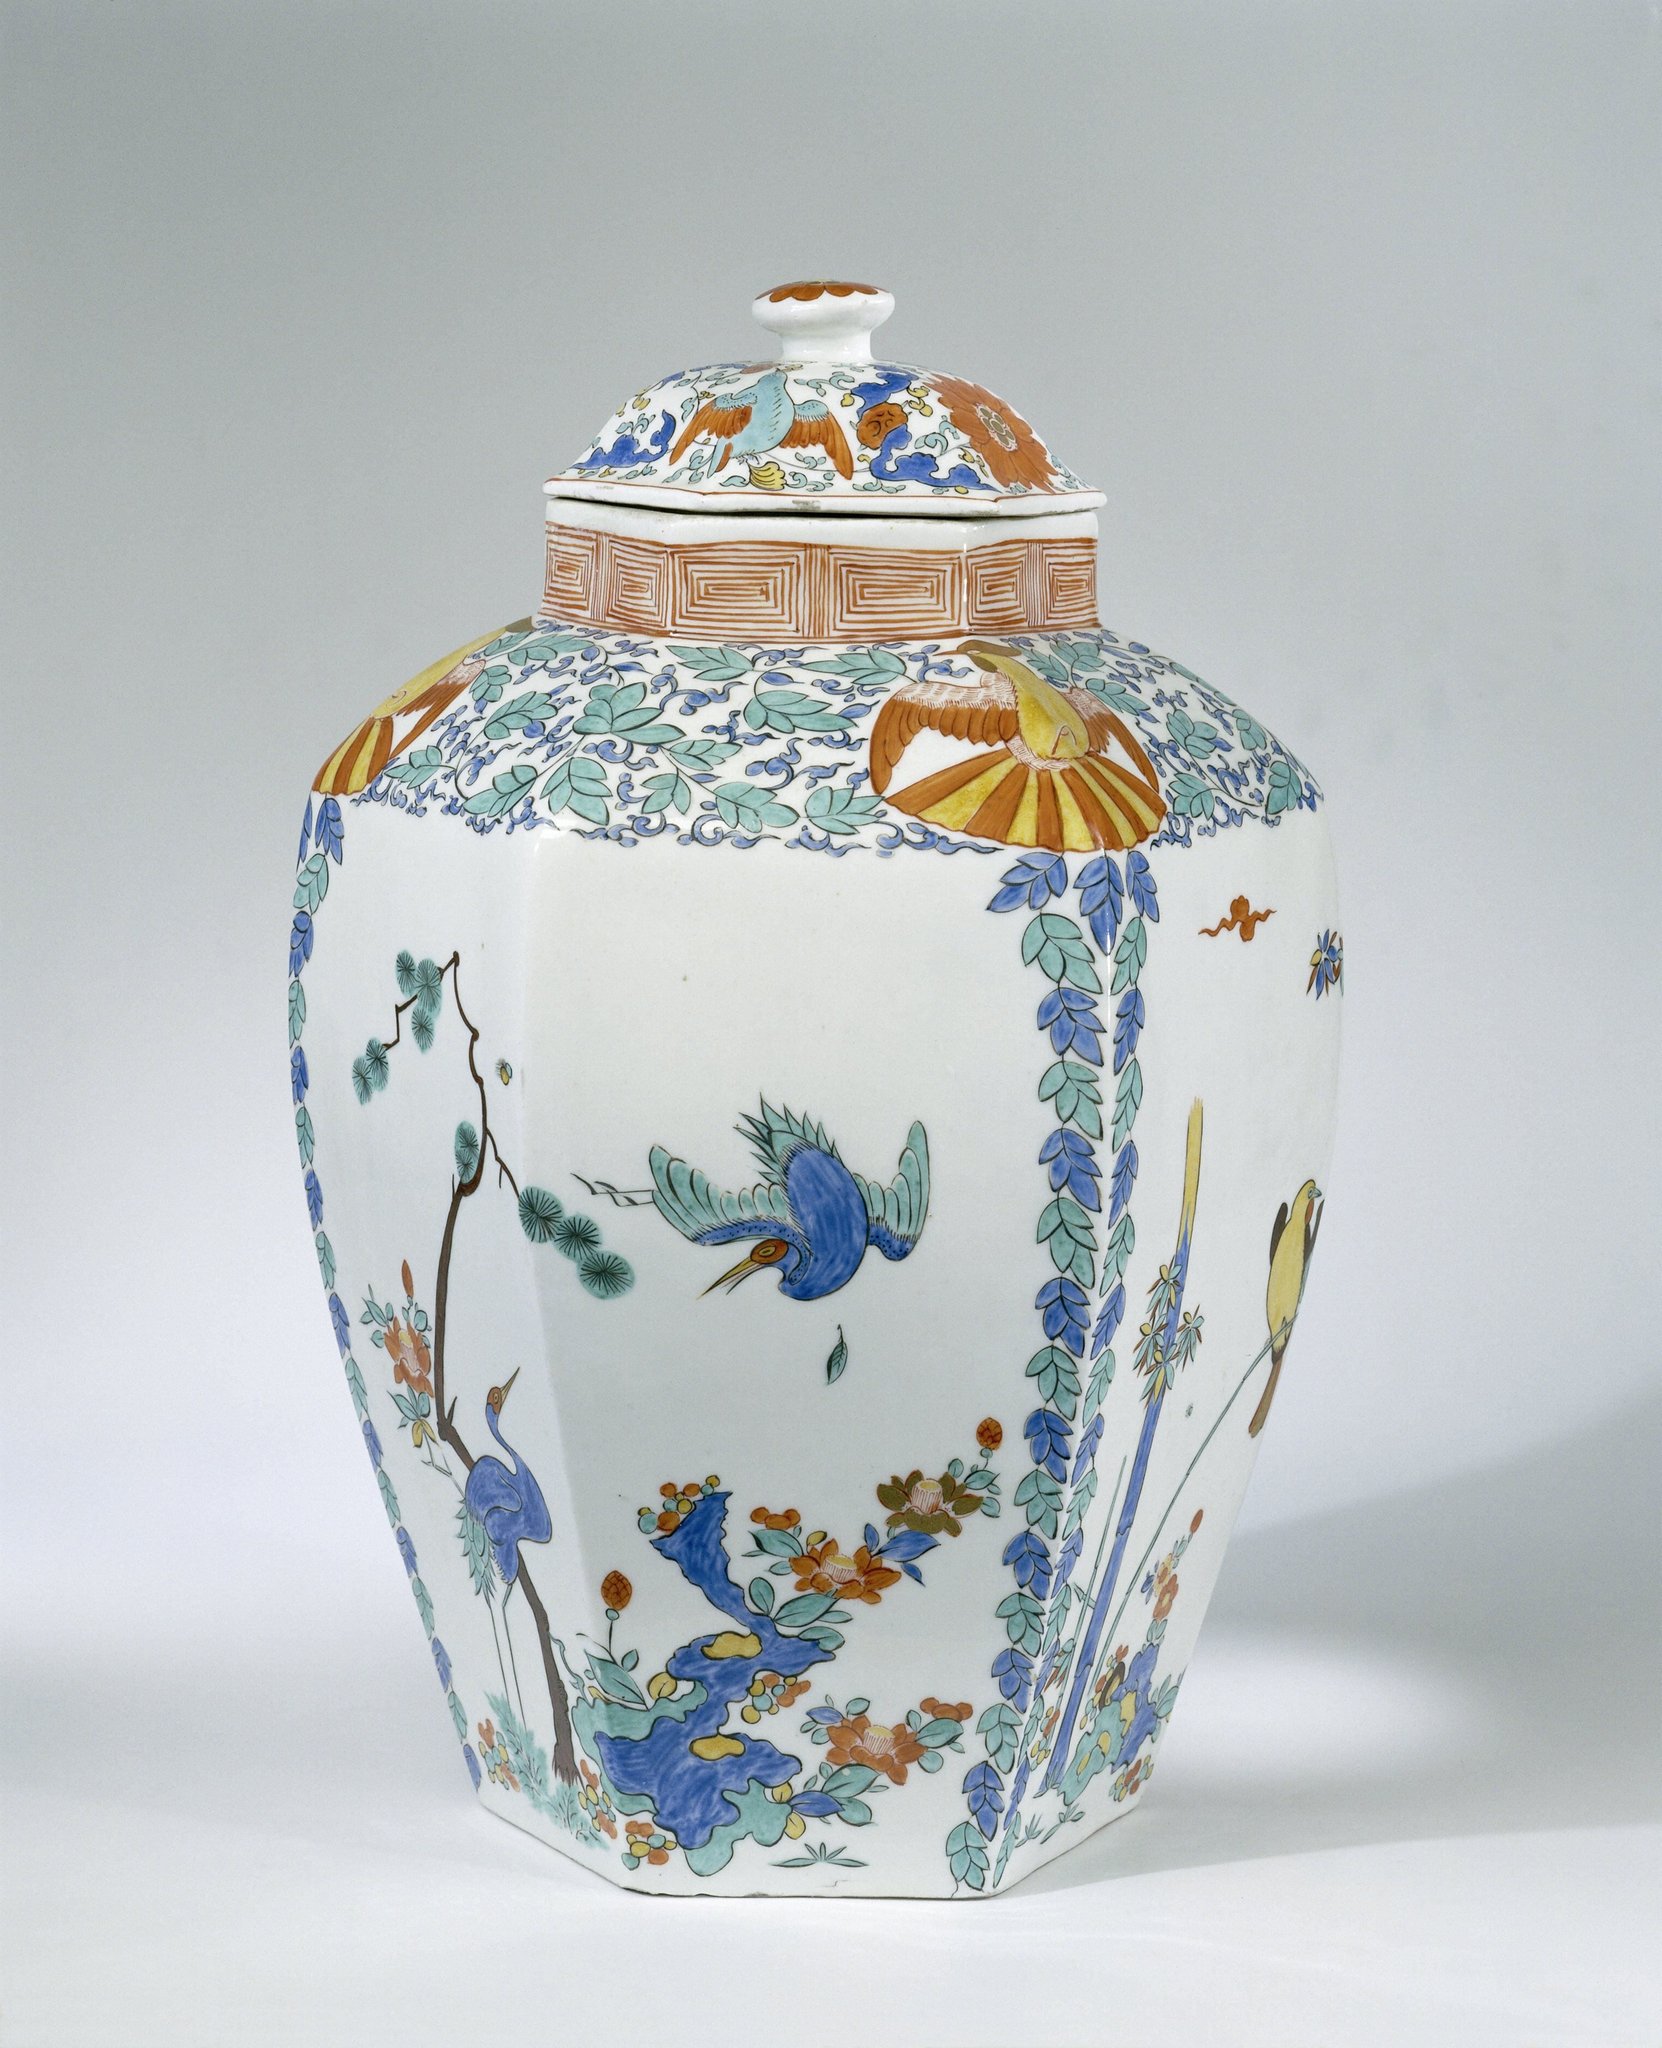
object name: vase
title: Two lidded vases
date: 1725-1730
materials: porcelain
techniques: painted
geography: meissen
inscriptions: mark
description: Meissener Porzellan Manufaktur Meissen, c. 1725–1730 hard-paste porcelain